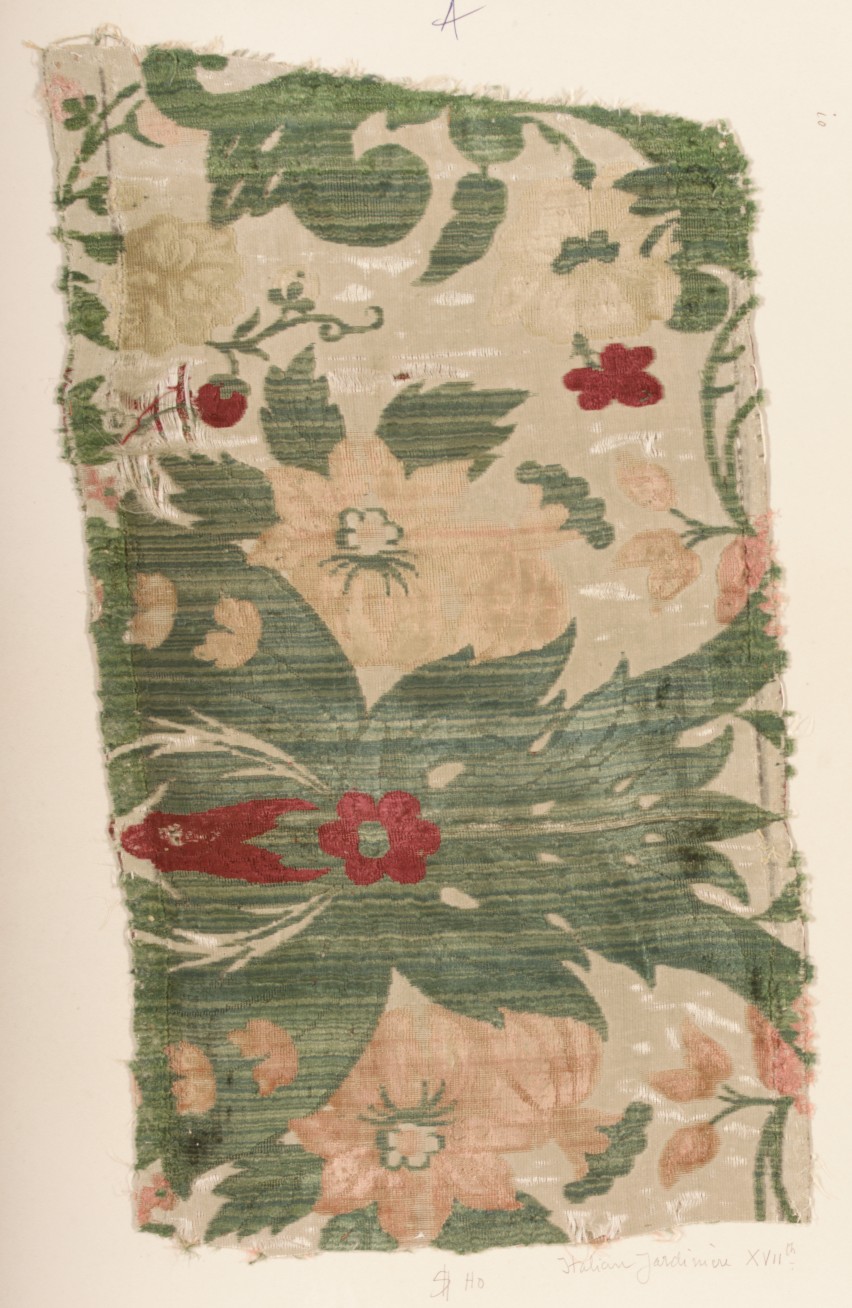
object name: fragment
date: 1601-1700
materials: silk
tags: flowers,leaves